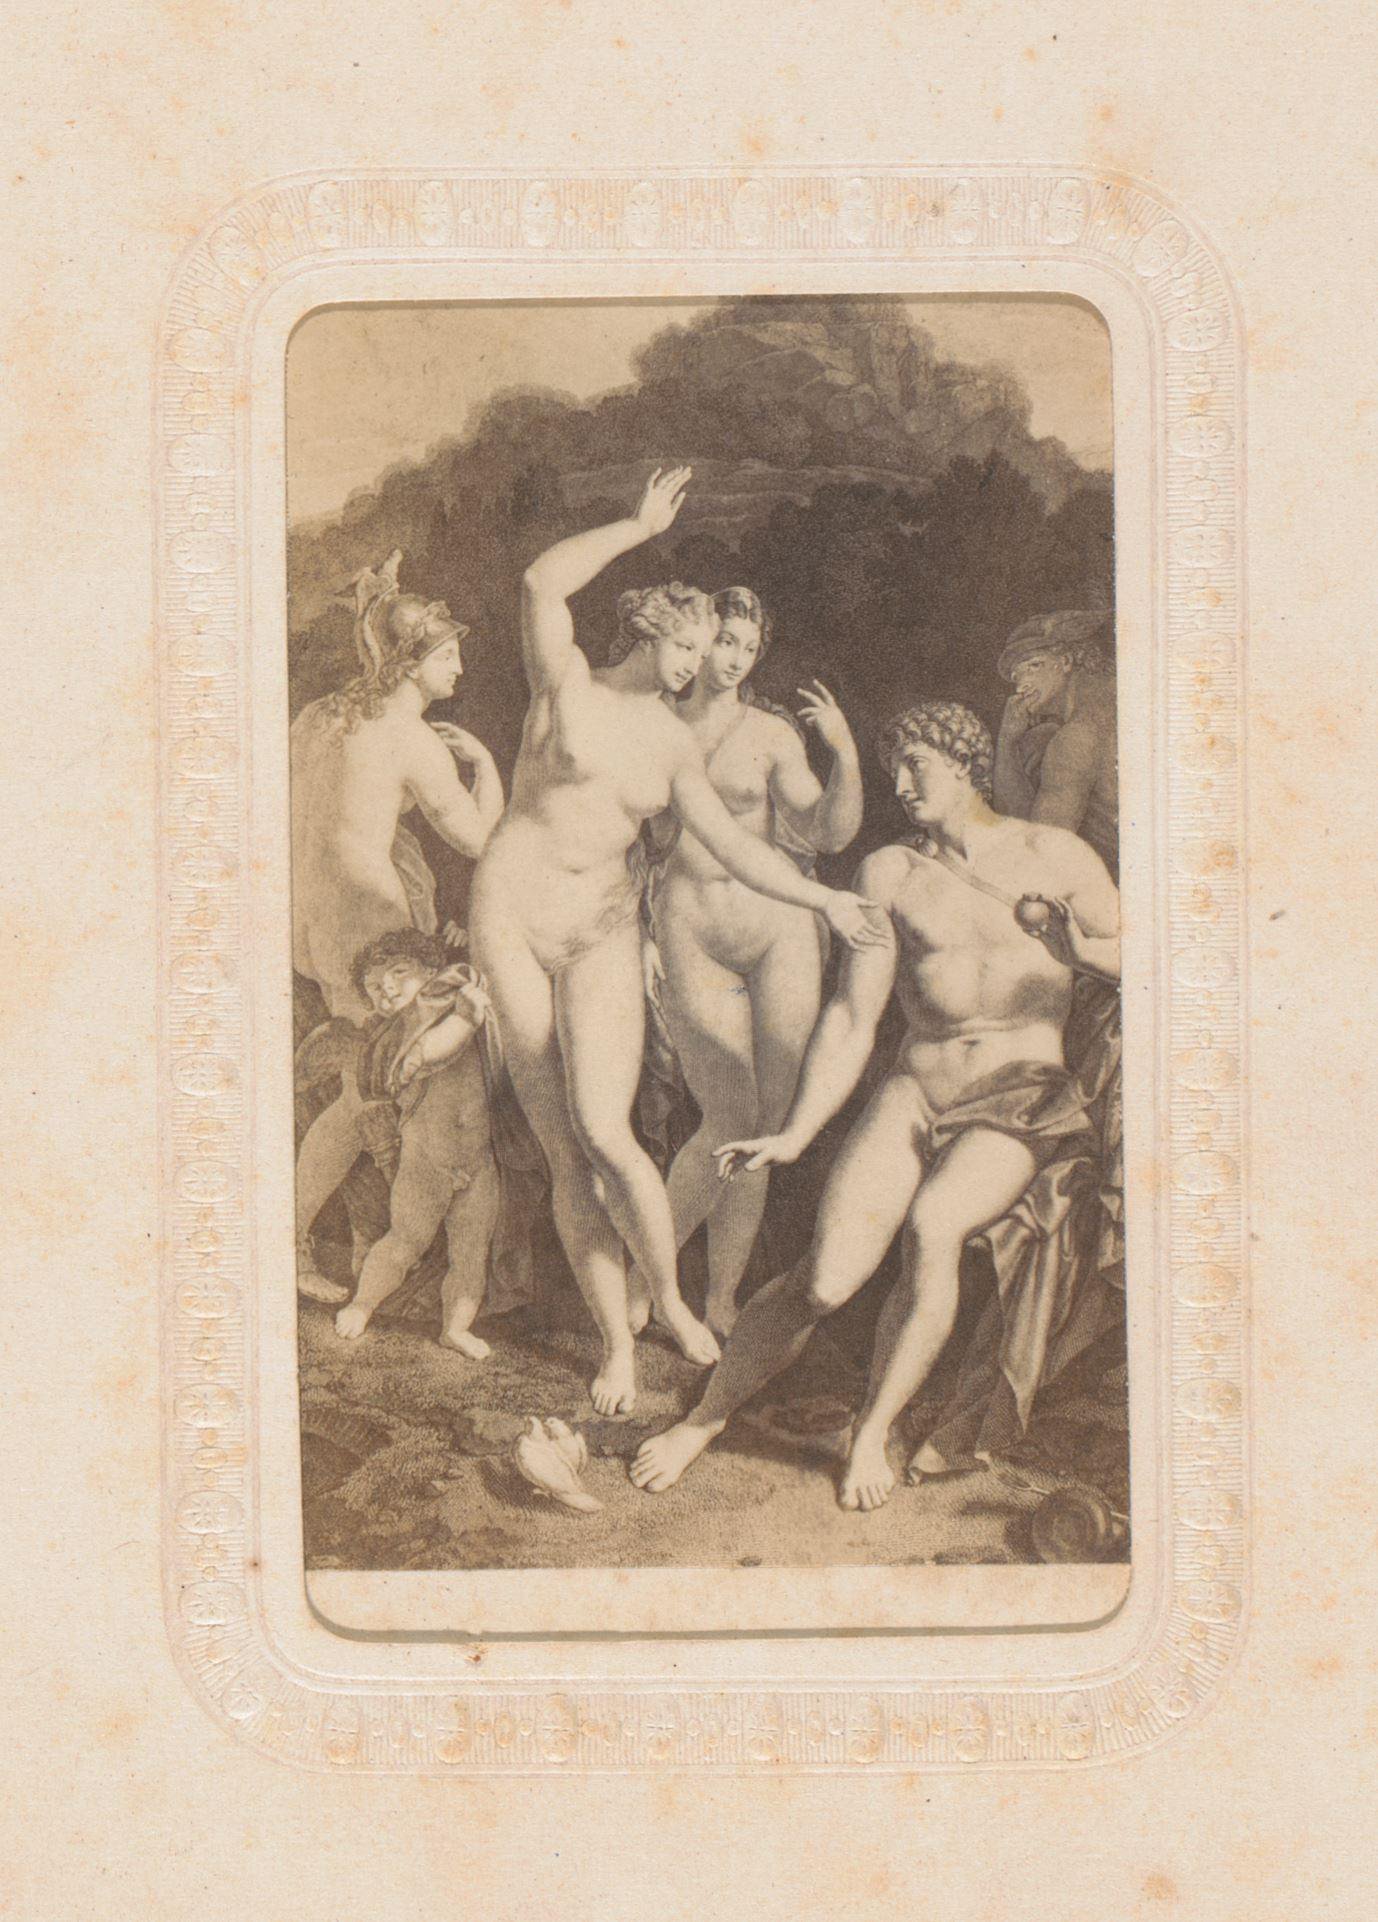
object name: reproduction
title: Fotoreproductie van een prent met het Parisoordeel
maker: Anonymous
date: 1855-1865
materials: cardboard, photographic support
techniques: albumen print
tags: the judgement of paris (without mercury)